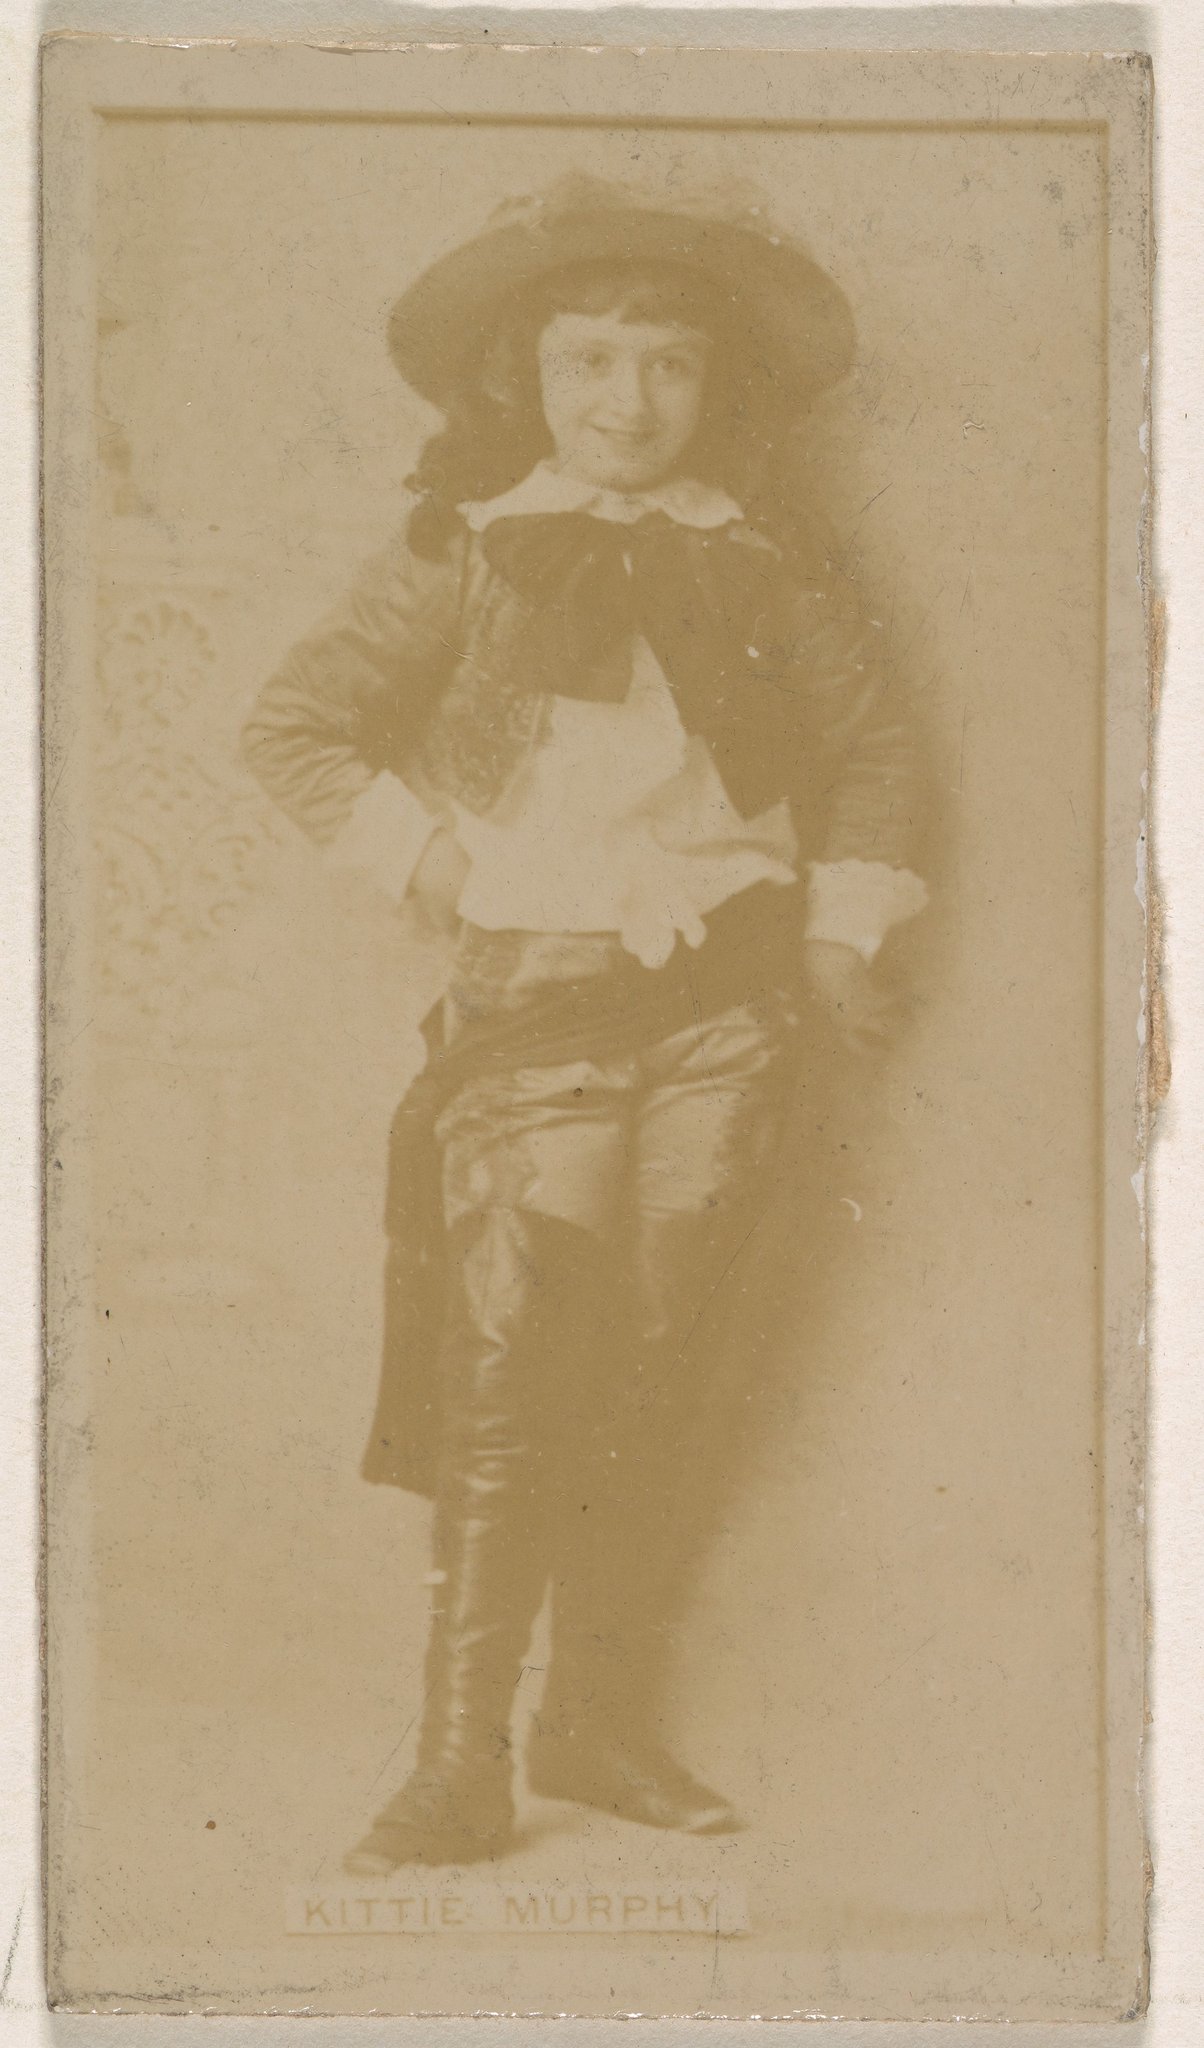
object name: photograph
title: Kittie Murphy, from the Actresses series (N245) issued by Kinney Brothers to promote Sweet Caporal Cigarettes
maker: kinney brothers tobacco company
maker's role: publisher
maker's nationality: american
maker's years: 1869-2011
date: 1890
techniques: albumen silver print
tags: girls,portraits,actresses